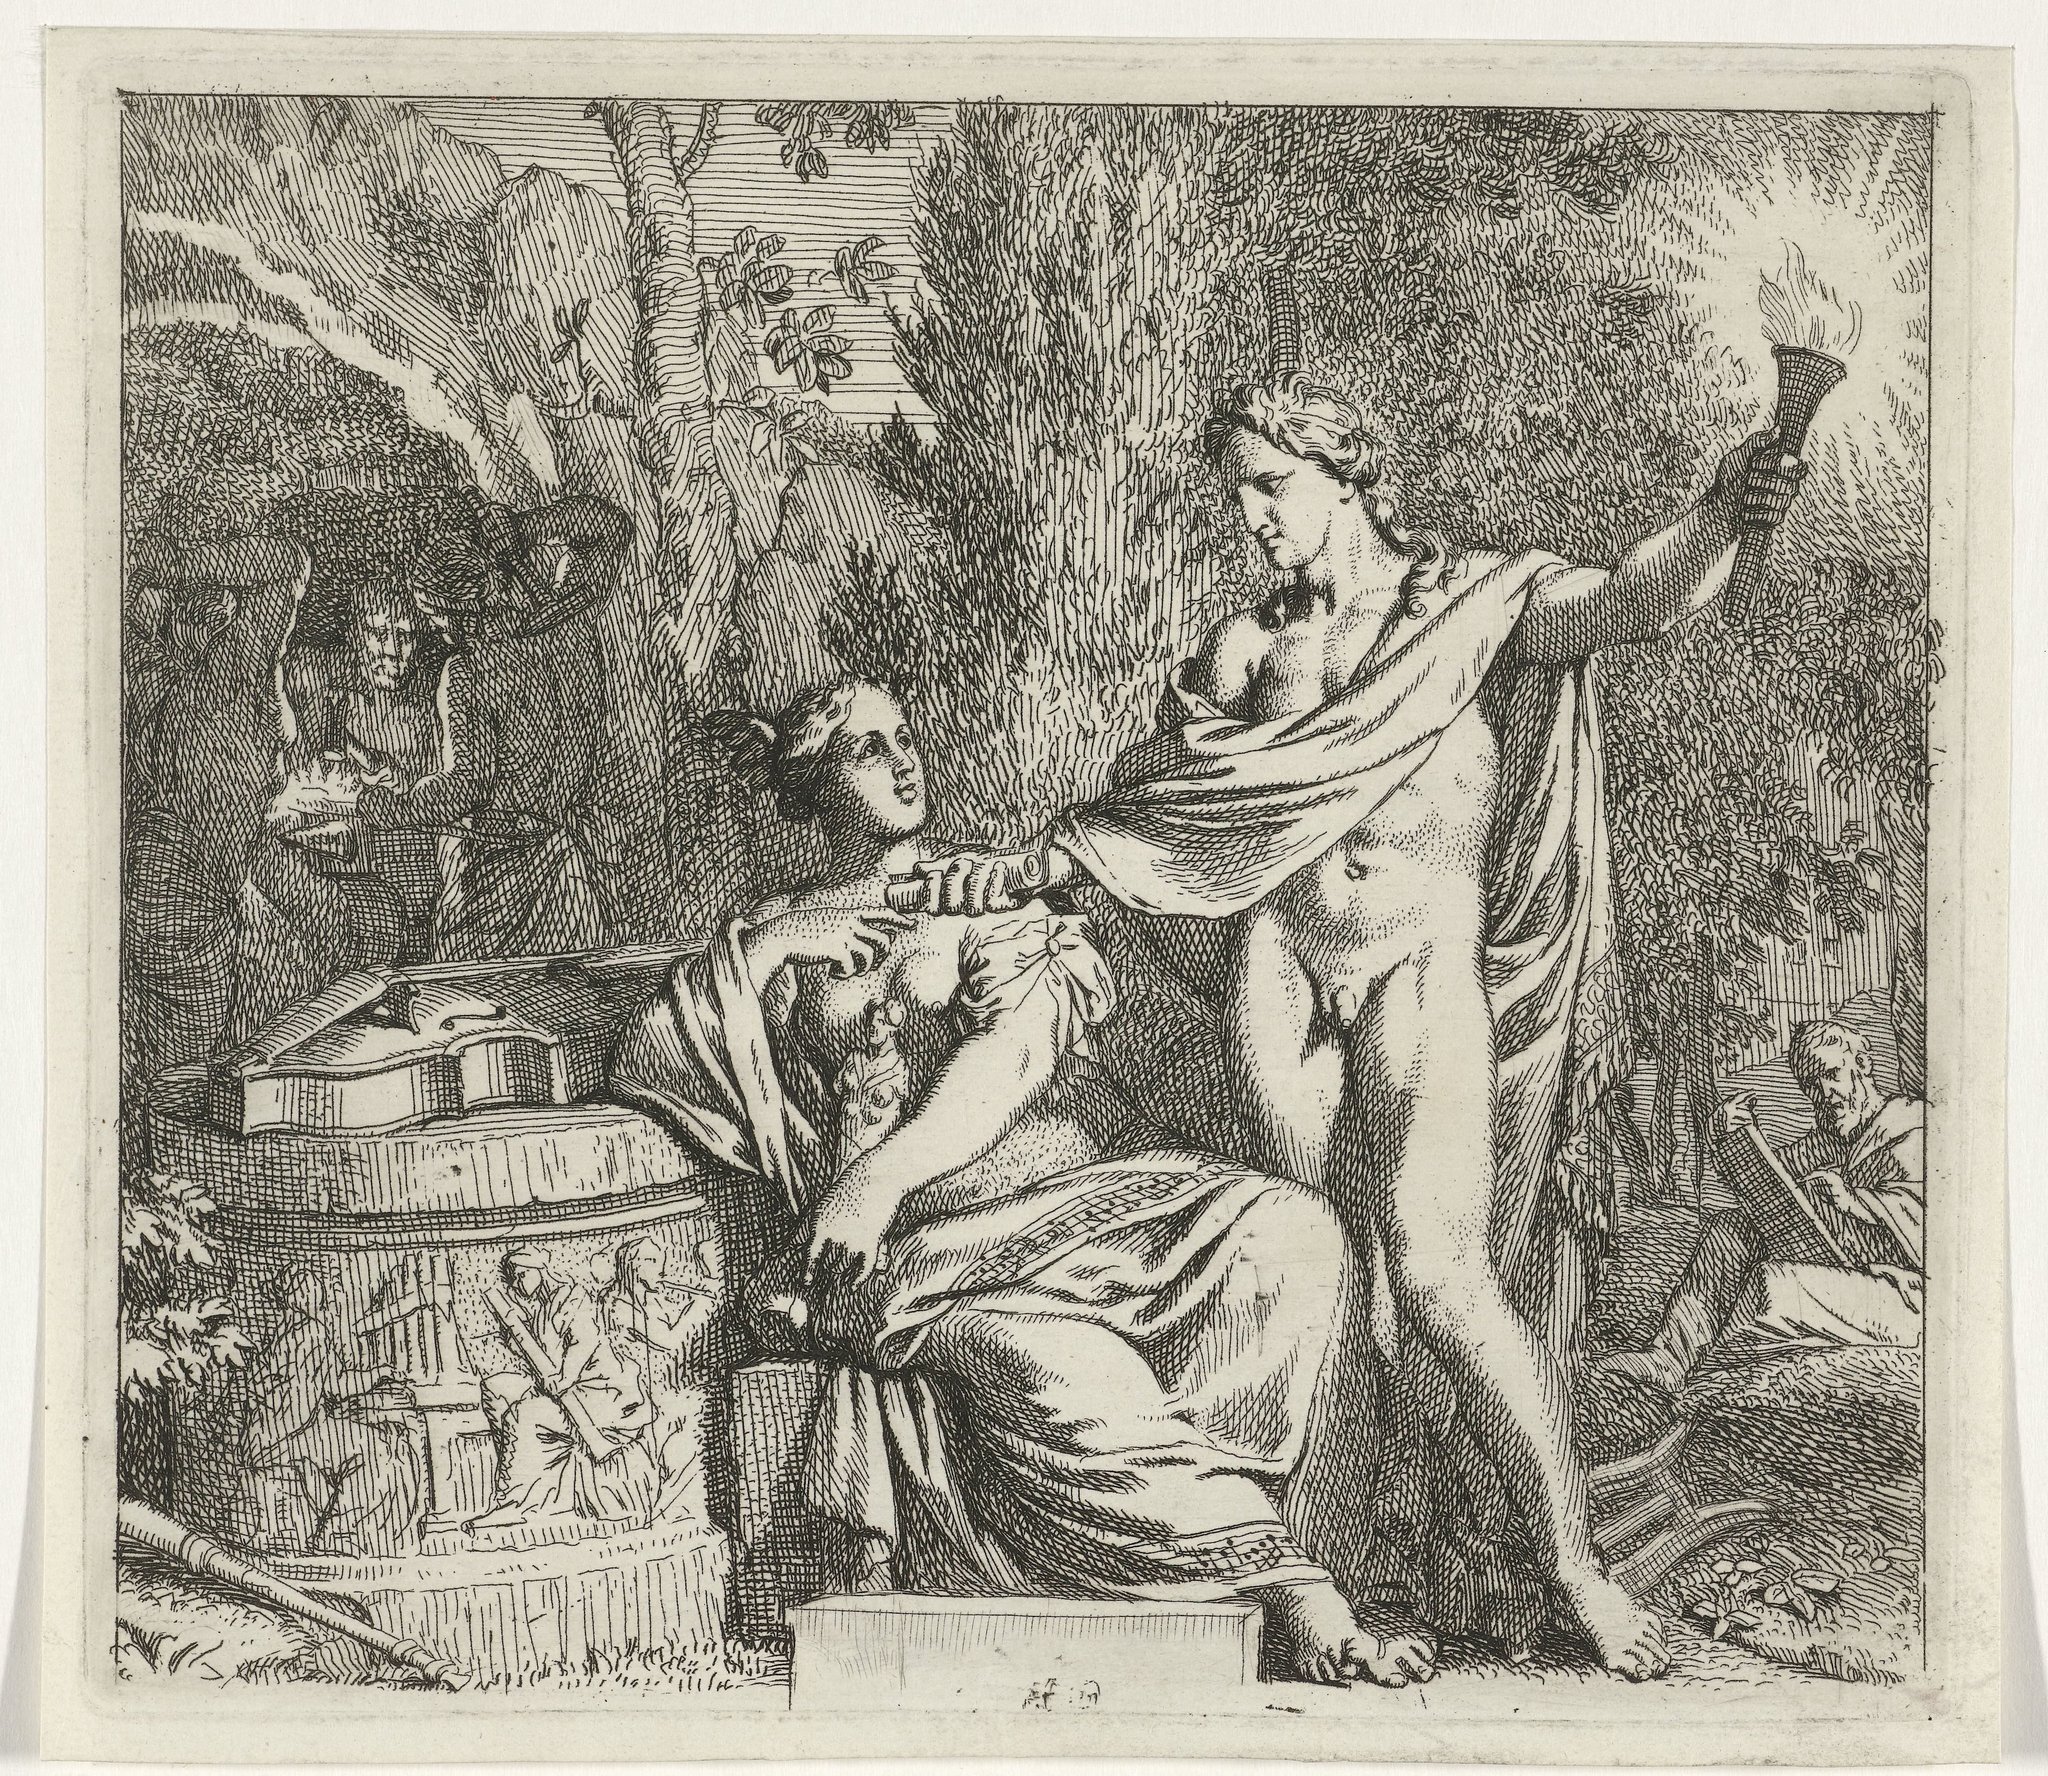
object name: print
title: Apollo en de inventie van muziek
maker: gerard de lairesse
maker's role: draughtsman, painter, print maker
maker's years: 1641-1711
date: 1675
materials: paper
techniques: etching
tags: the cyclopes forging, (story of) apollo (phoebus), (story of the) muses; 'muse' (ripa)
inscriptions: collector's mark: Lugt 240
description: Apollo staat met een brandende fakkel naast een Muze die gehuld is in een met muzieknoten versierd kleed. Haar arm steunt op een zuil waarop een viola ligt. Het reliëf van de zuil toont muziek spelende Muzen. Links op de achtergrond staan cyclopen met hamers rond een aambeeld, rechts zit een figuur te musiceren.